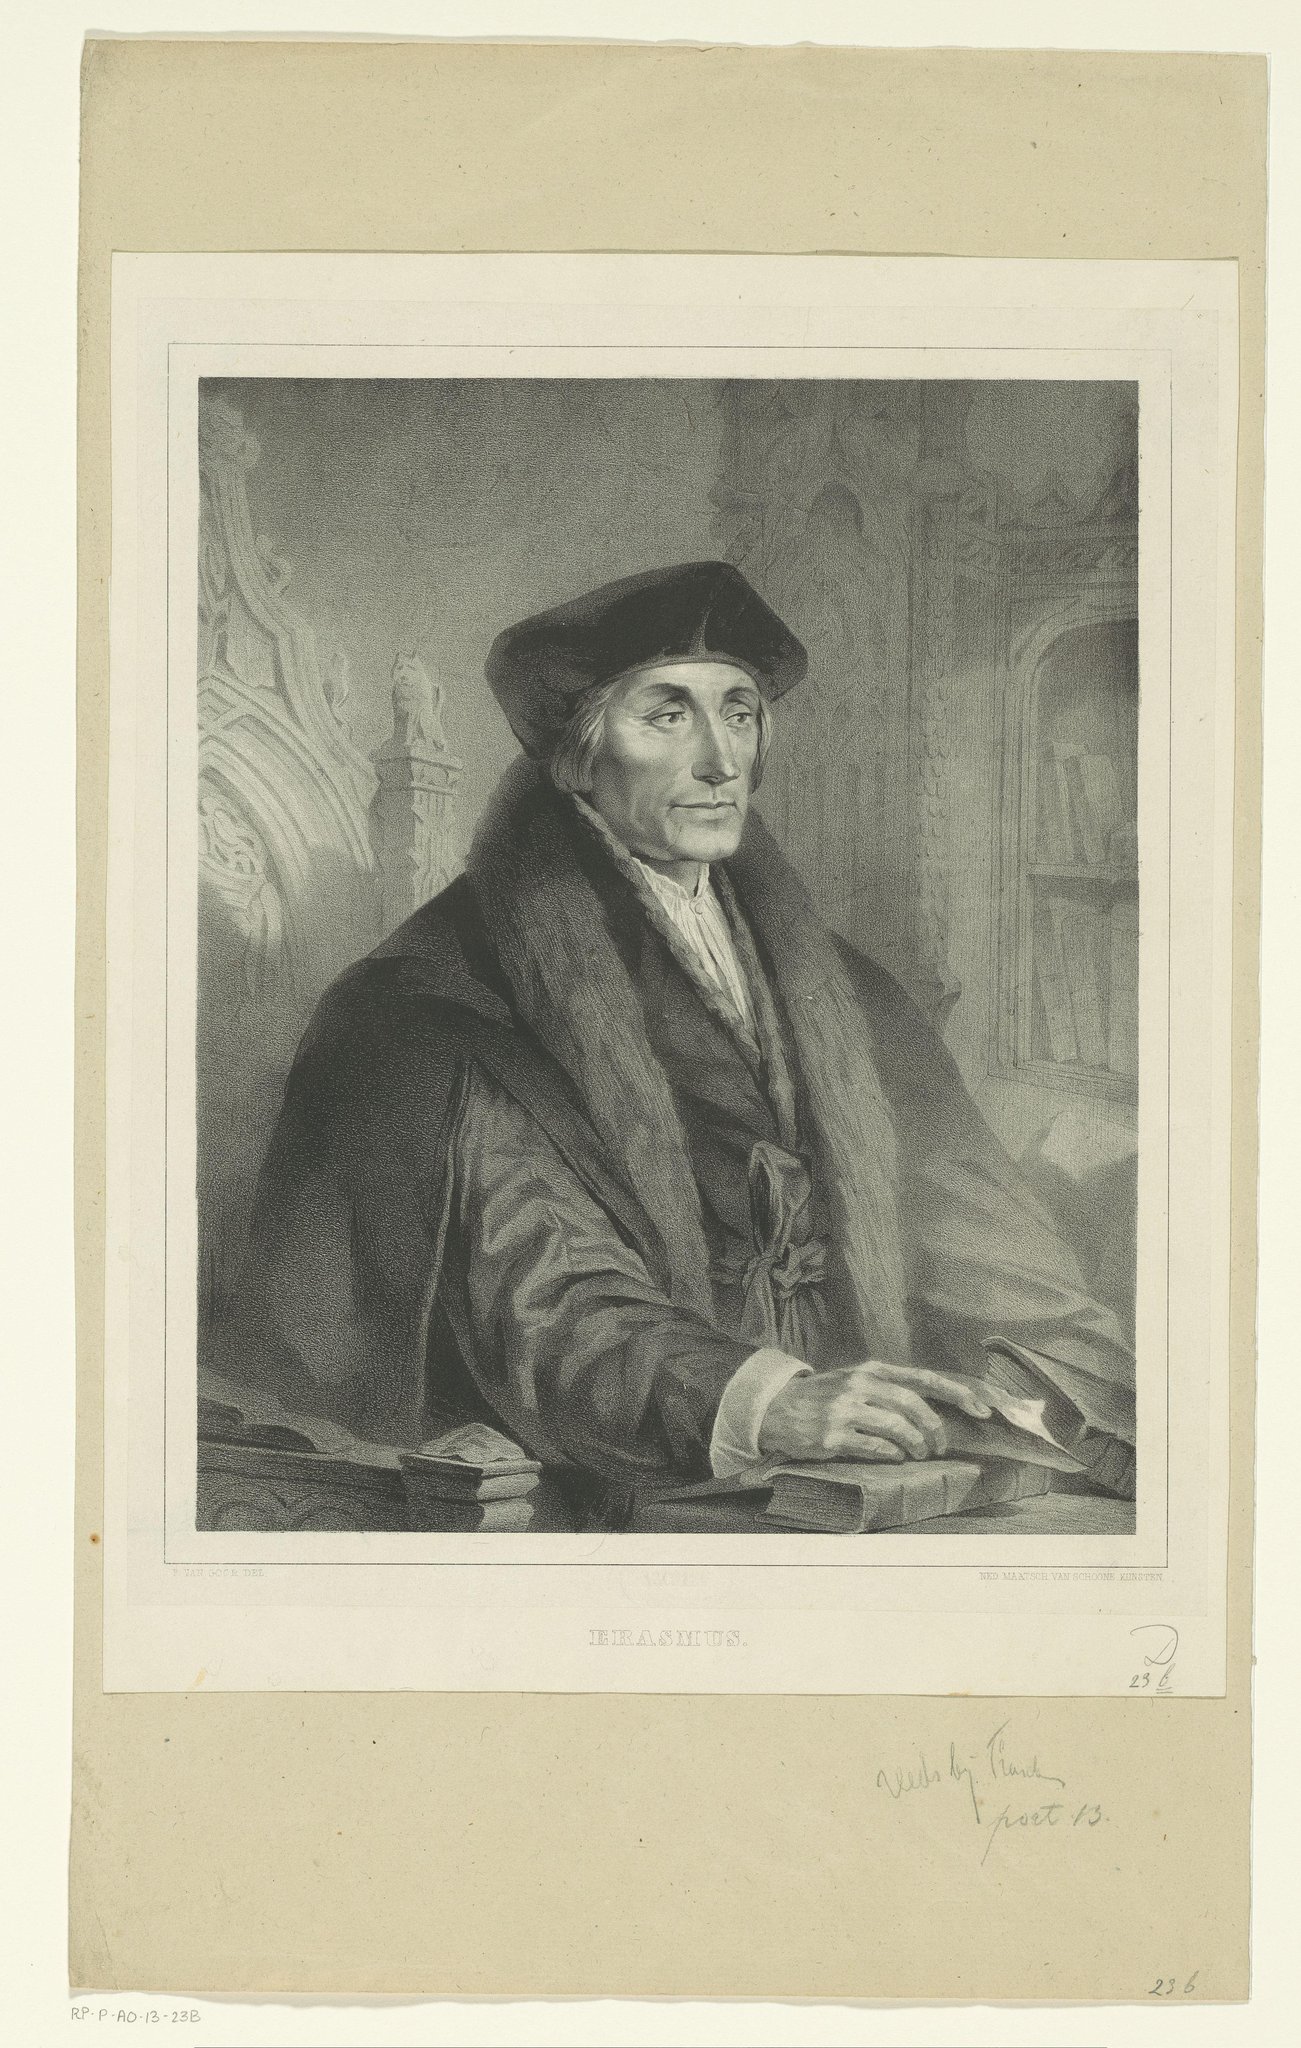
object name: print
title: Erasmus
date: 1840-1843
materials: paper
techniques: lithograph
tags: rotterdam, desiderius erasmus, bookshelves, historical persons, historical persons (+ half-length portrait)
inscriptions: check stamp: ‘Archief Ministerie van Oorlog Afdeeling Genie’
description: De geportretteerde zit op een gedecoreerde stoel. Voor hem liggen boeken en papieren, rechts een boekenkast. Hij draagt een mantel afgezet met bont.